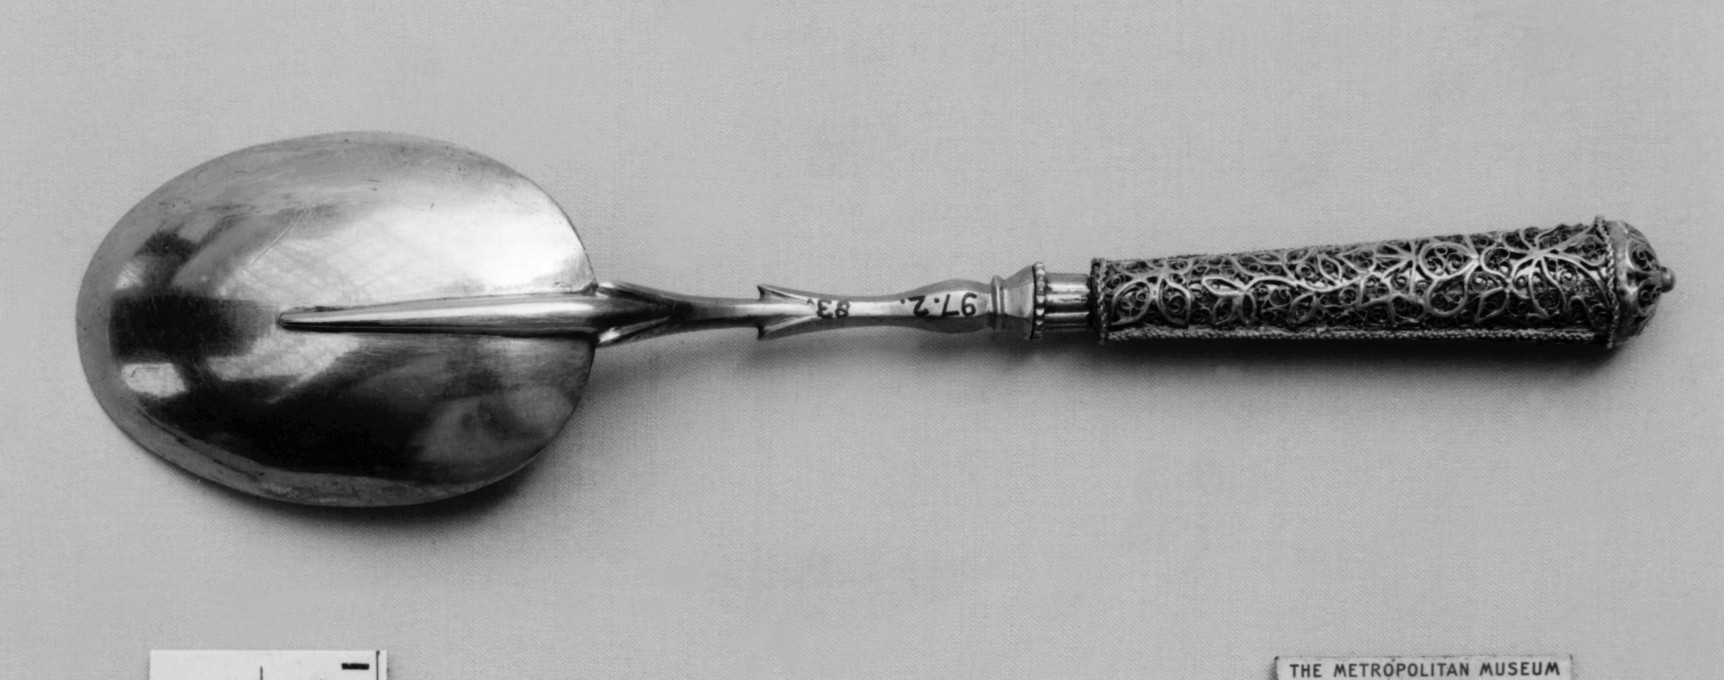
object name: spoon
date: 1601-1700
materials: gilt, silver